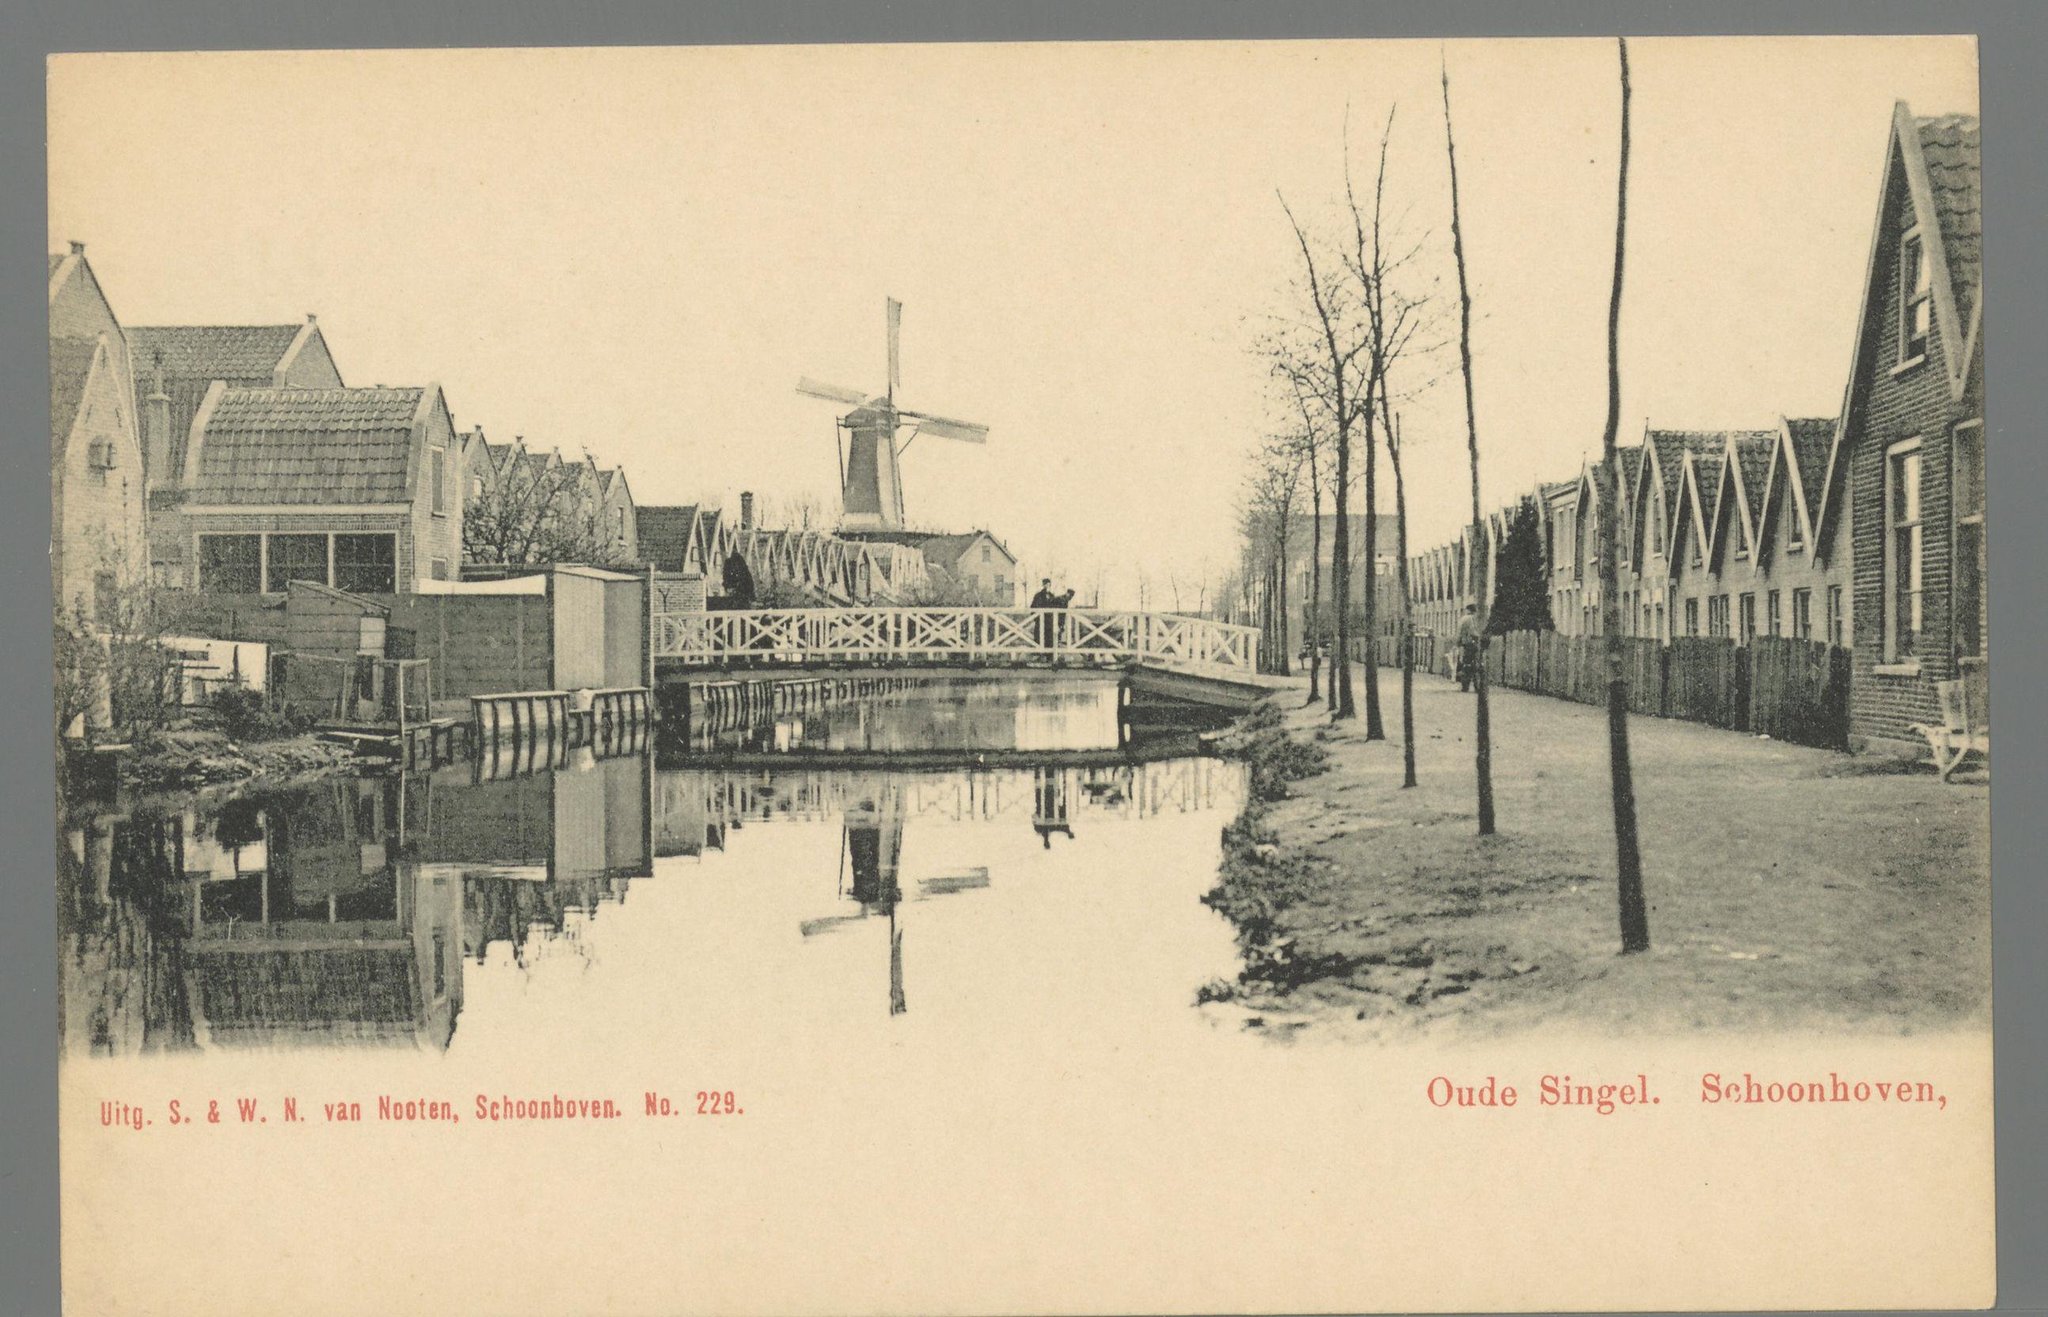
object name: ansichtkaart, prentbriefkaart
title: Oude Singel. Schoonhoven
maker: Anonymous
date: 1897-1905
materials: cardboard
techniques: photograph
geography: schoonhoven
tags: canals, waters (in city), windmill, street